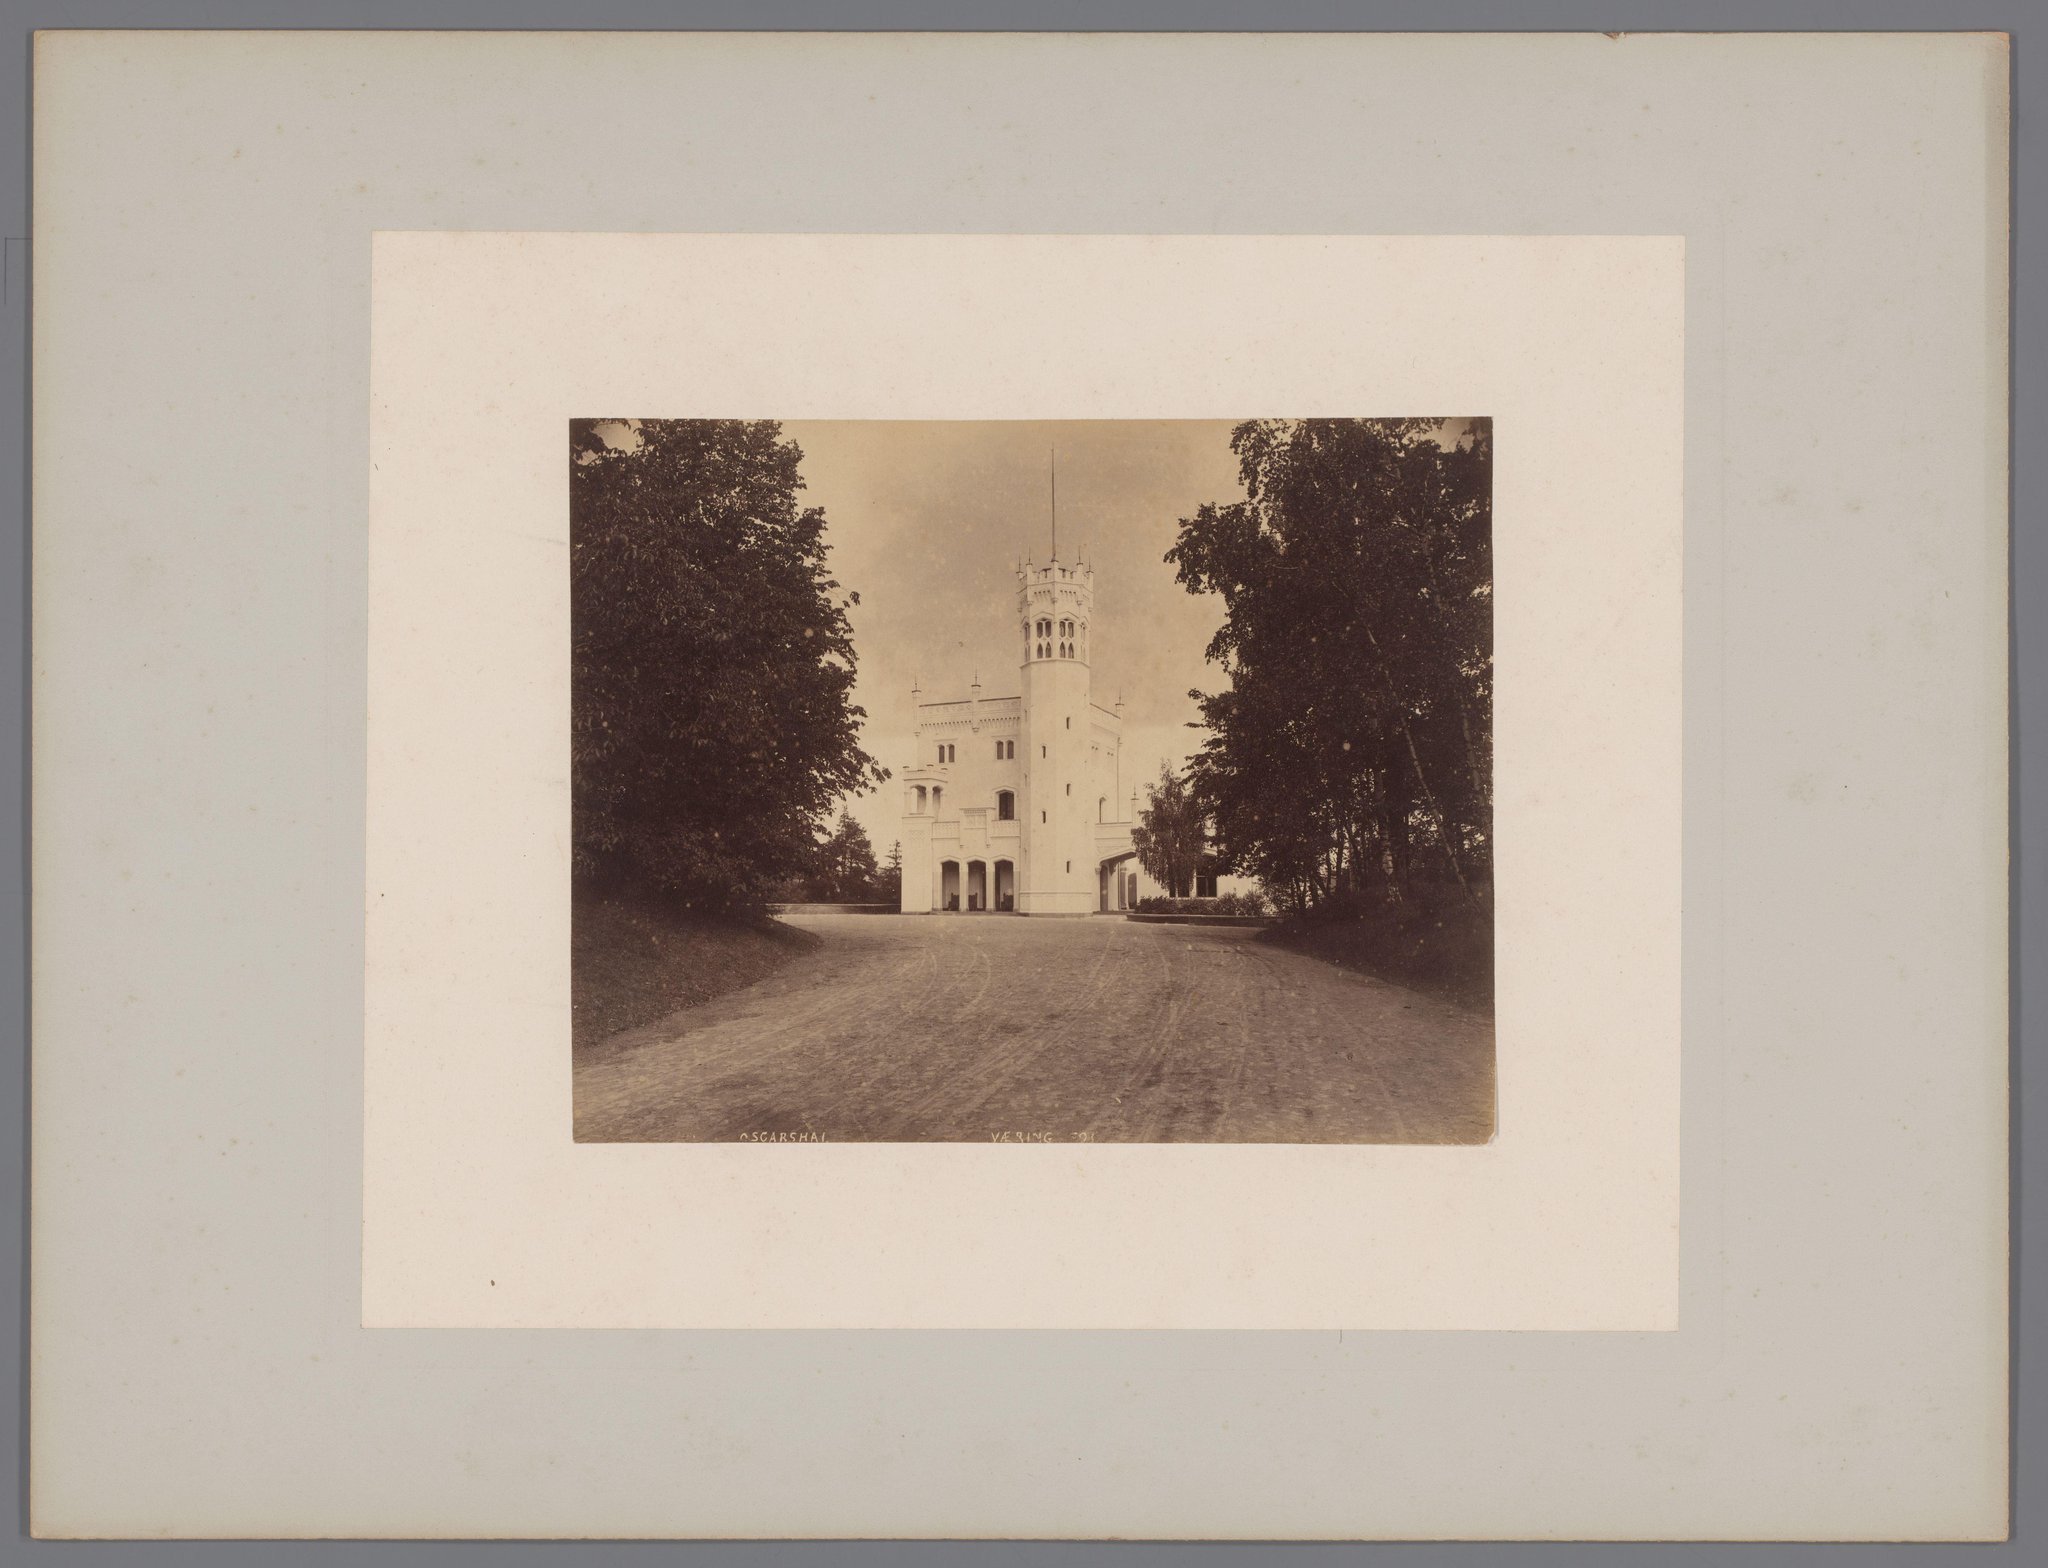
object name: photograph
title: Oscarshal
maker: Anonymous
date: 1860-1900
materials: cardboard, paper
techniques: albumen print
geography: oslo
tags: palace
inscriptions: inscription: ‘VAERING [...]01 [?]’